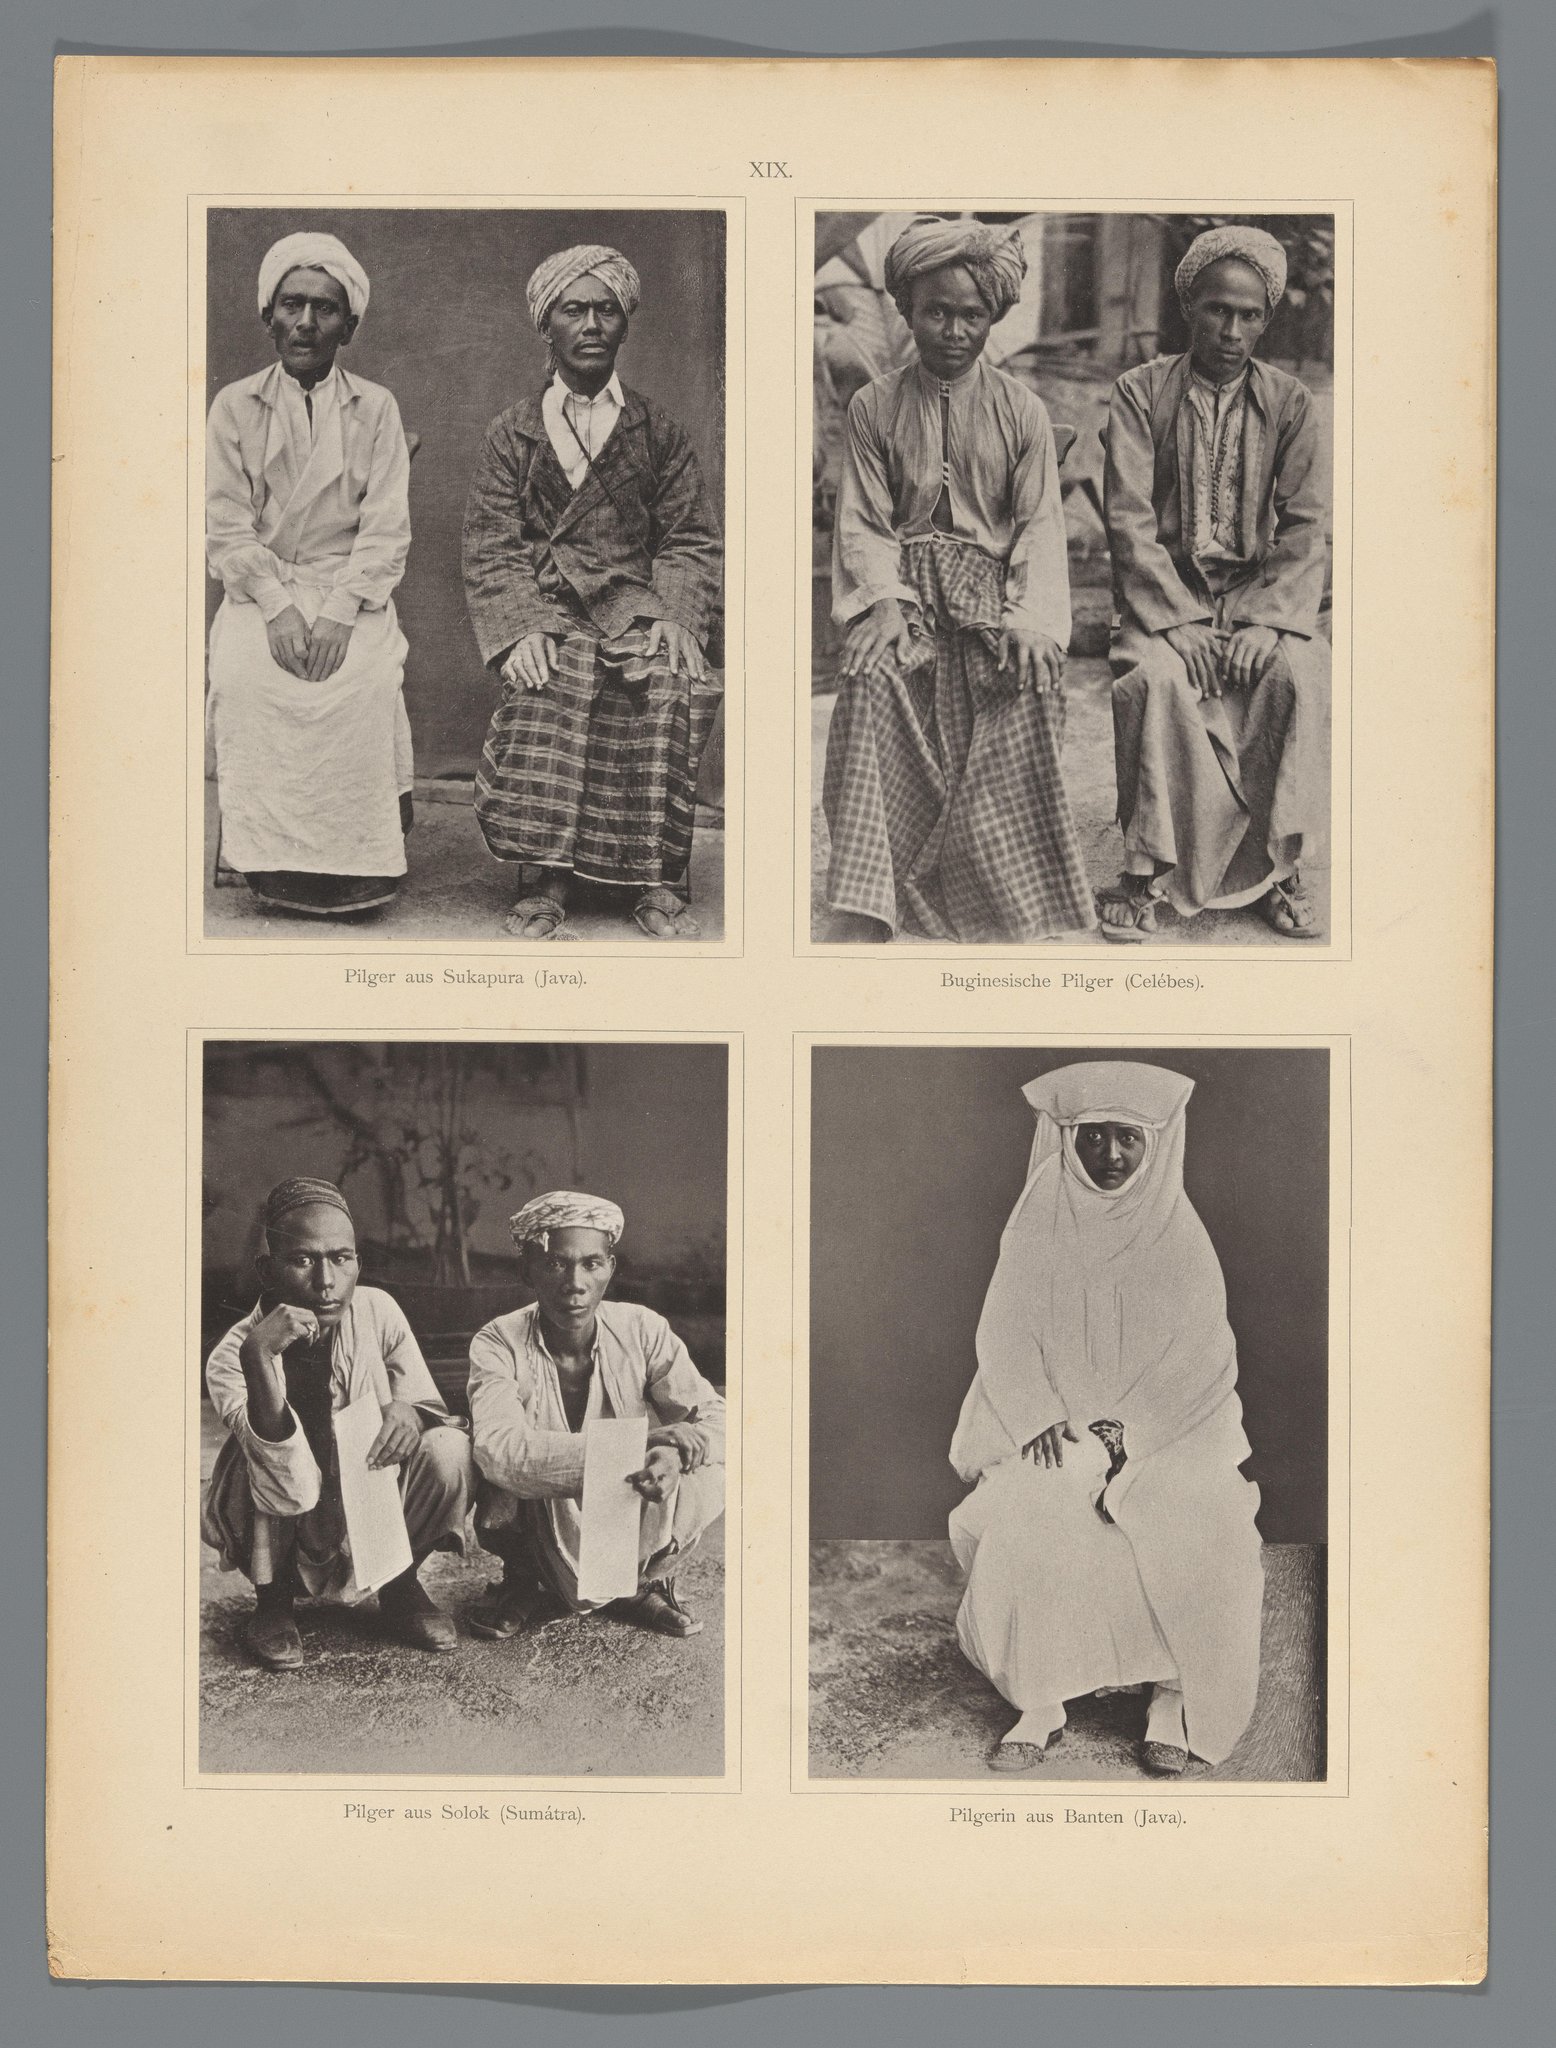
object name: photomechanical print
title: Vier portretten van pelgrims uit Nederlands-Indië, te Djedda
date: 1884-1888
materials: paper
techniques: photograph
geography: djedda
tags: the believer ~ islam, mohammedanism, anonymous historical person portrayed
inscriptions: number: ‘XIX.’